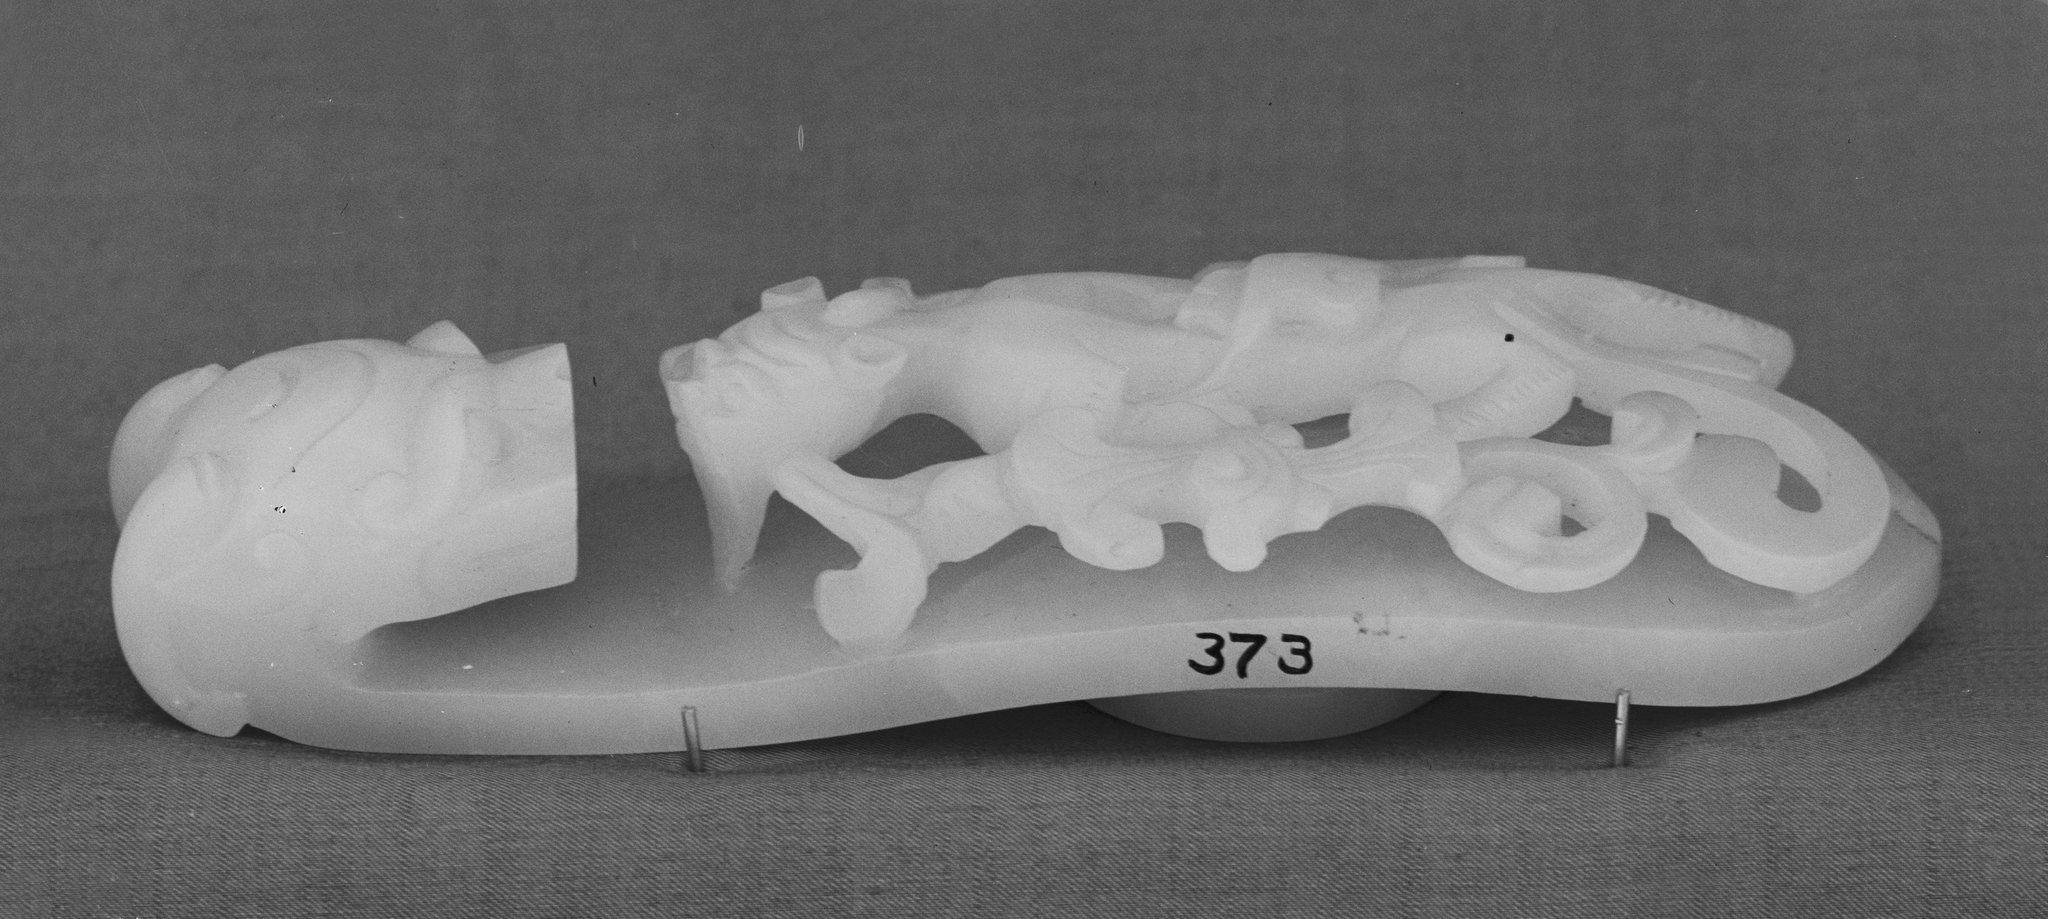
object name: girdle buckle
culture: chinese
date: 1368-1644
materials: jade